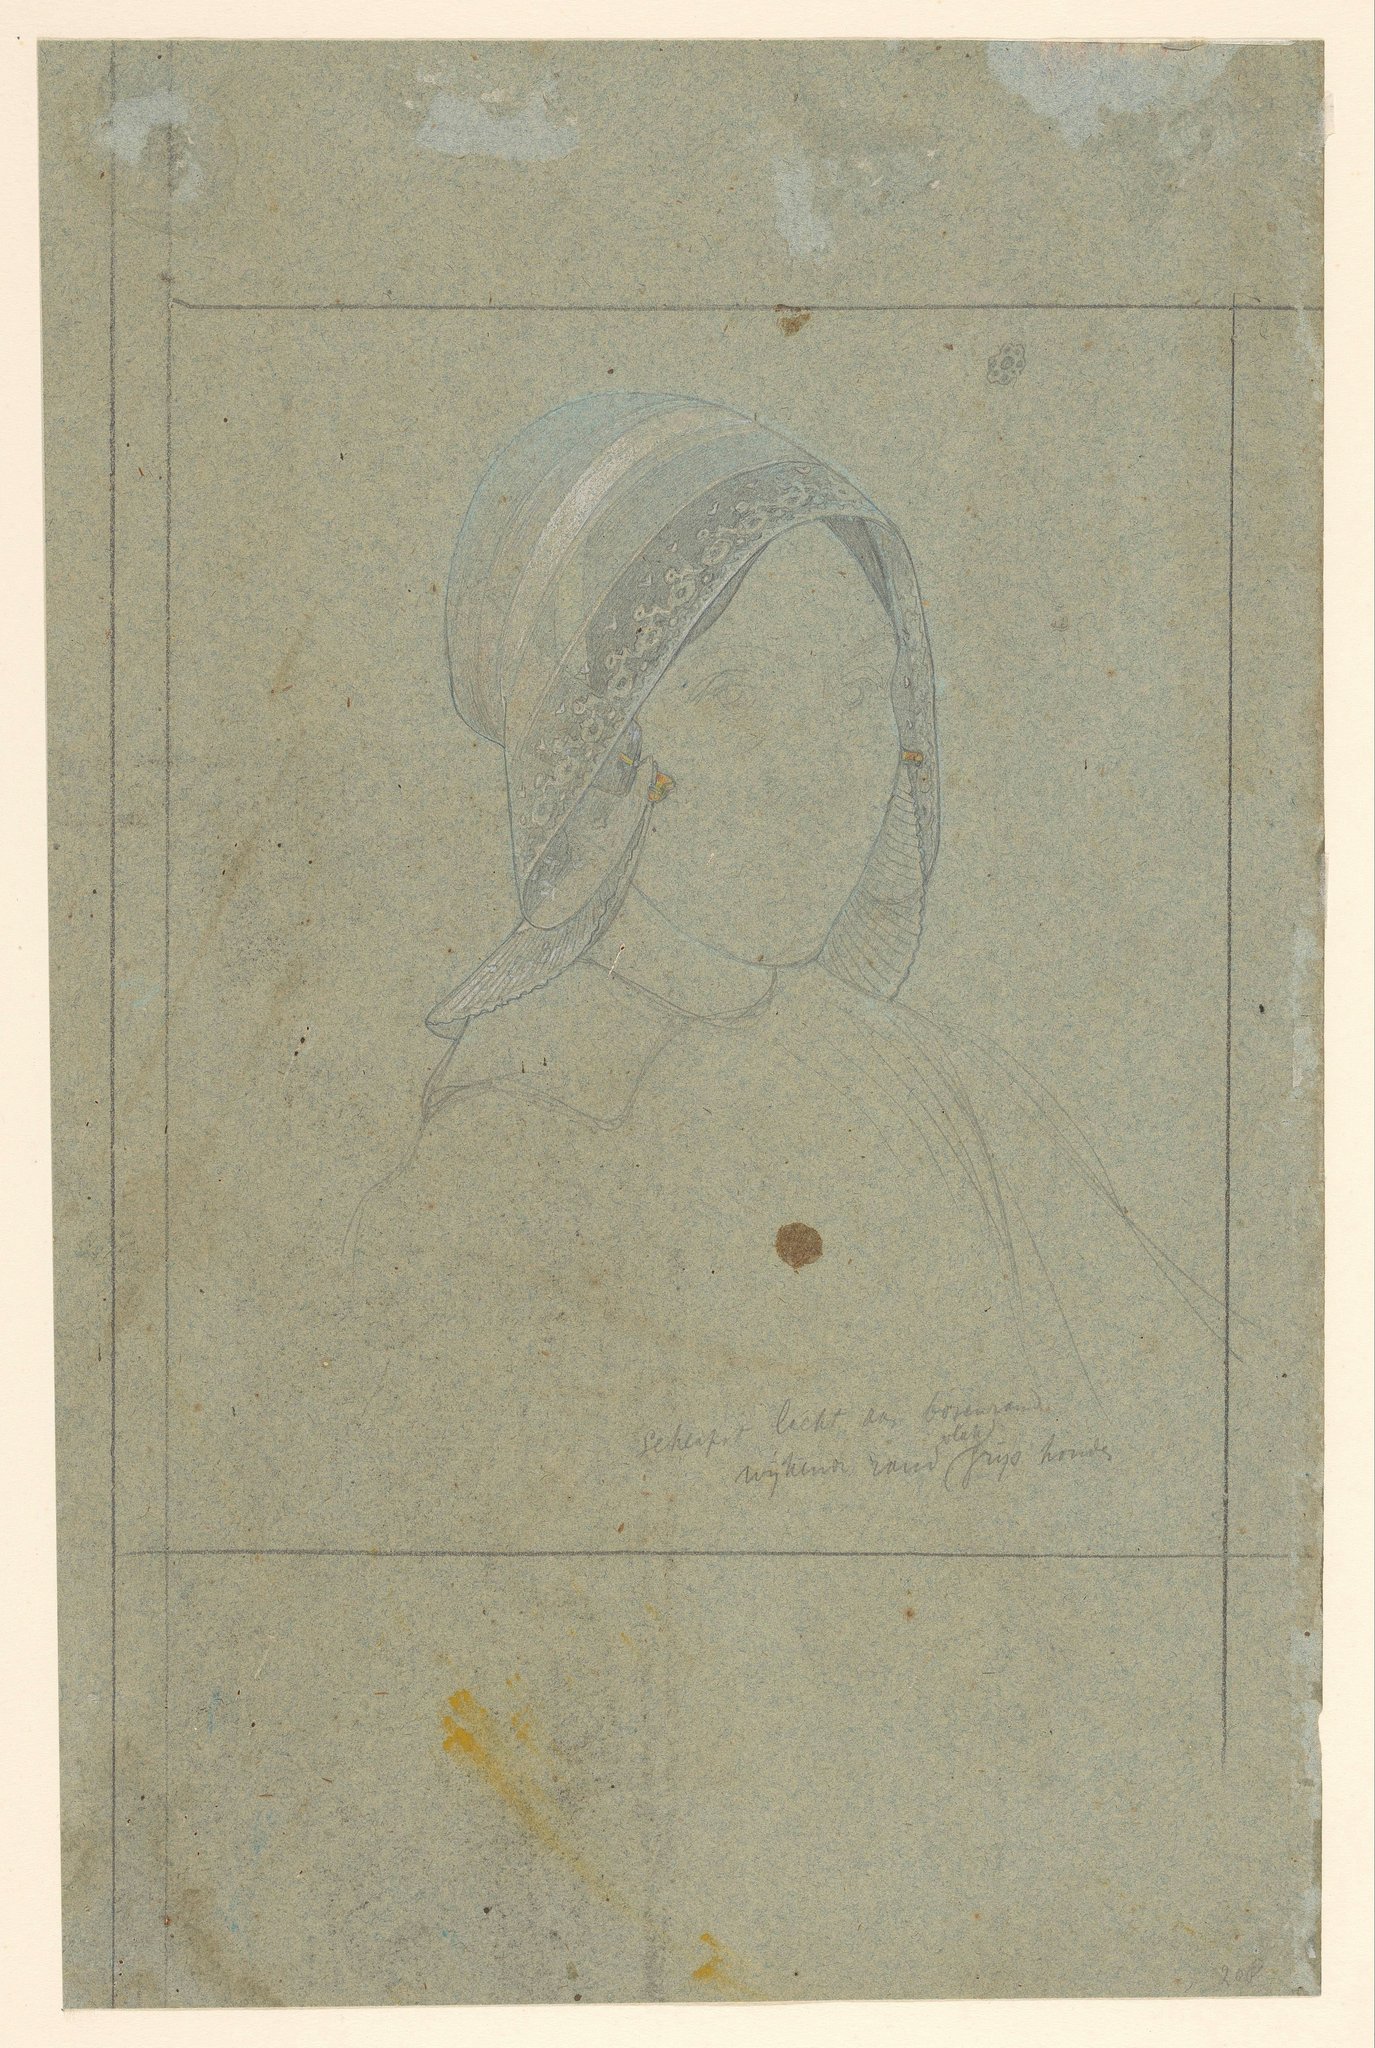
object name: drawing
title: Jonge vrouw met kap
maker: jan veth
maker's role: designer, draughtsman, painter, print maker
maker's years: 1864-1925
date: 1874-1925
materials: chalk, paper, pencil